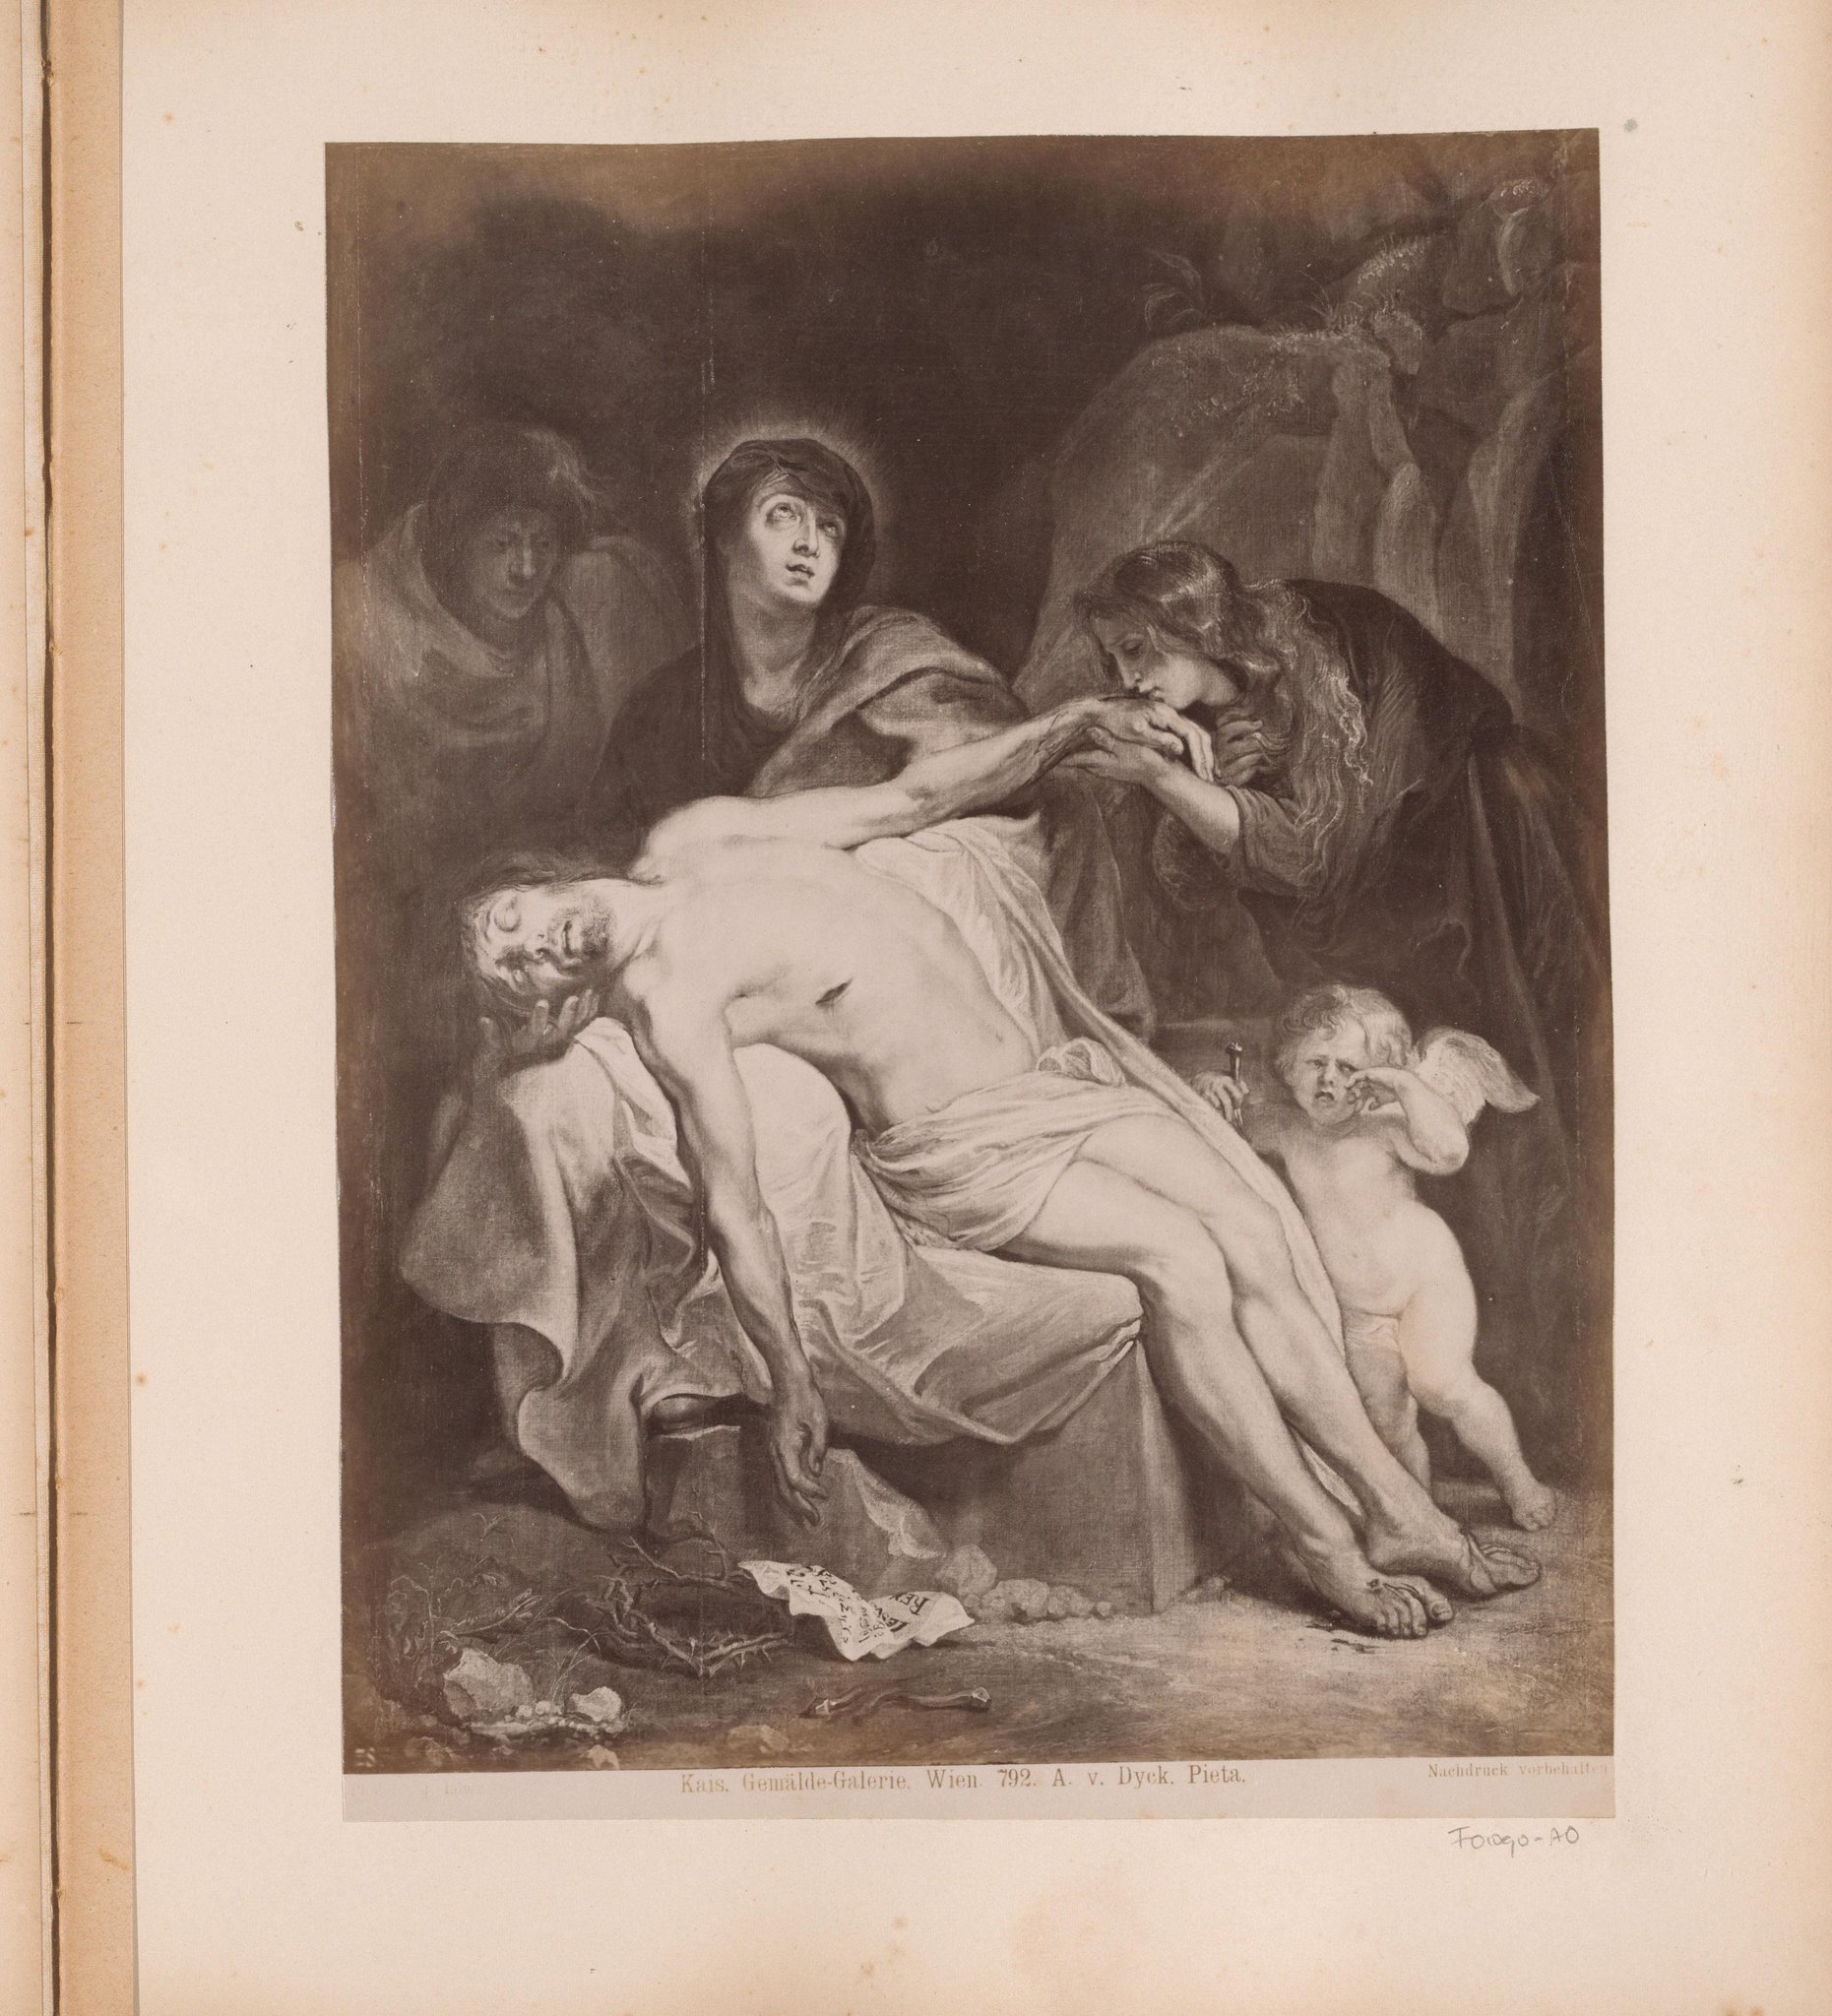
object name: photograph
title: Fotoreproductie van (vermoedelijk) een prent naar een schilderij van Anthony van Dyck, voorstellend de bewening van Christus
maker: Anonymous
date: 1870-1900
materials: paper, photographic support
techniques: albumen print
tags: lamentation over the dead christ by his relatives and friends (christ usually without crown of thorns)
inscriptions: negative number: ‘792’, name: ‘[...]’, check stamp: ‘[...]’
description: Onderdeel van Reisalbum met foto's van bezienswaardigheden in Duitsland en Oostenrijk en van kunstwerken.